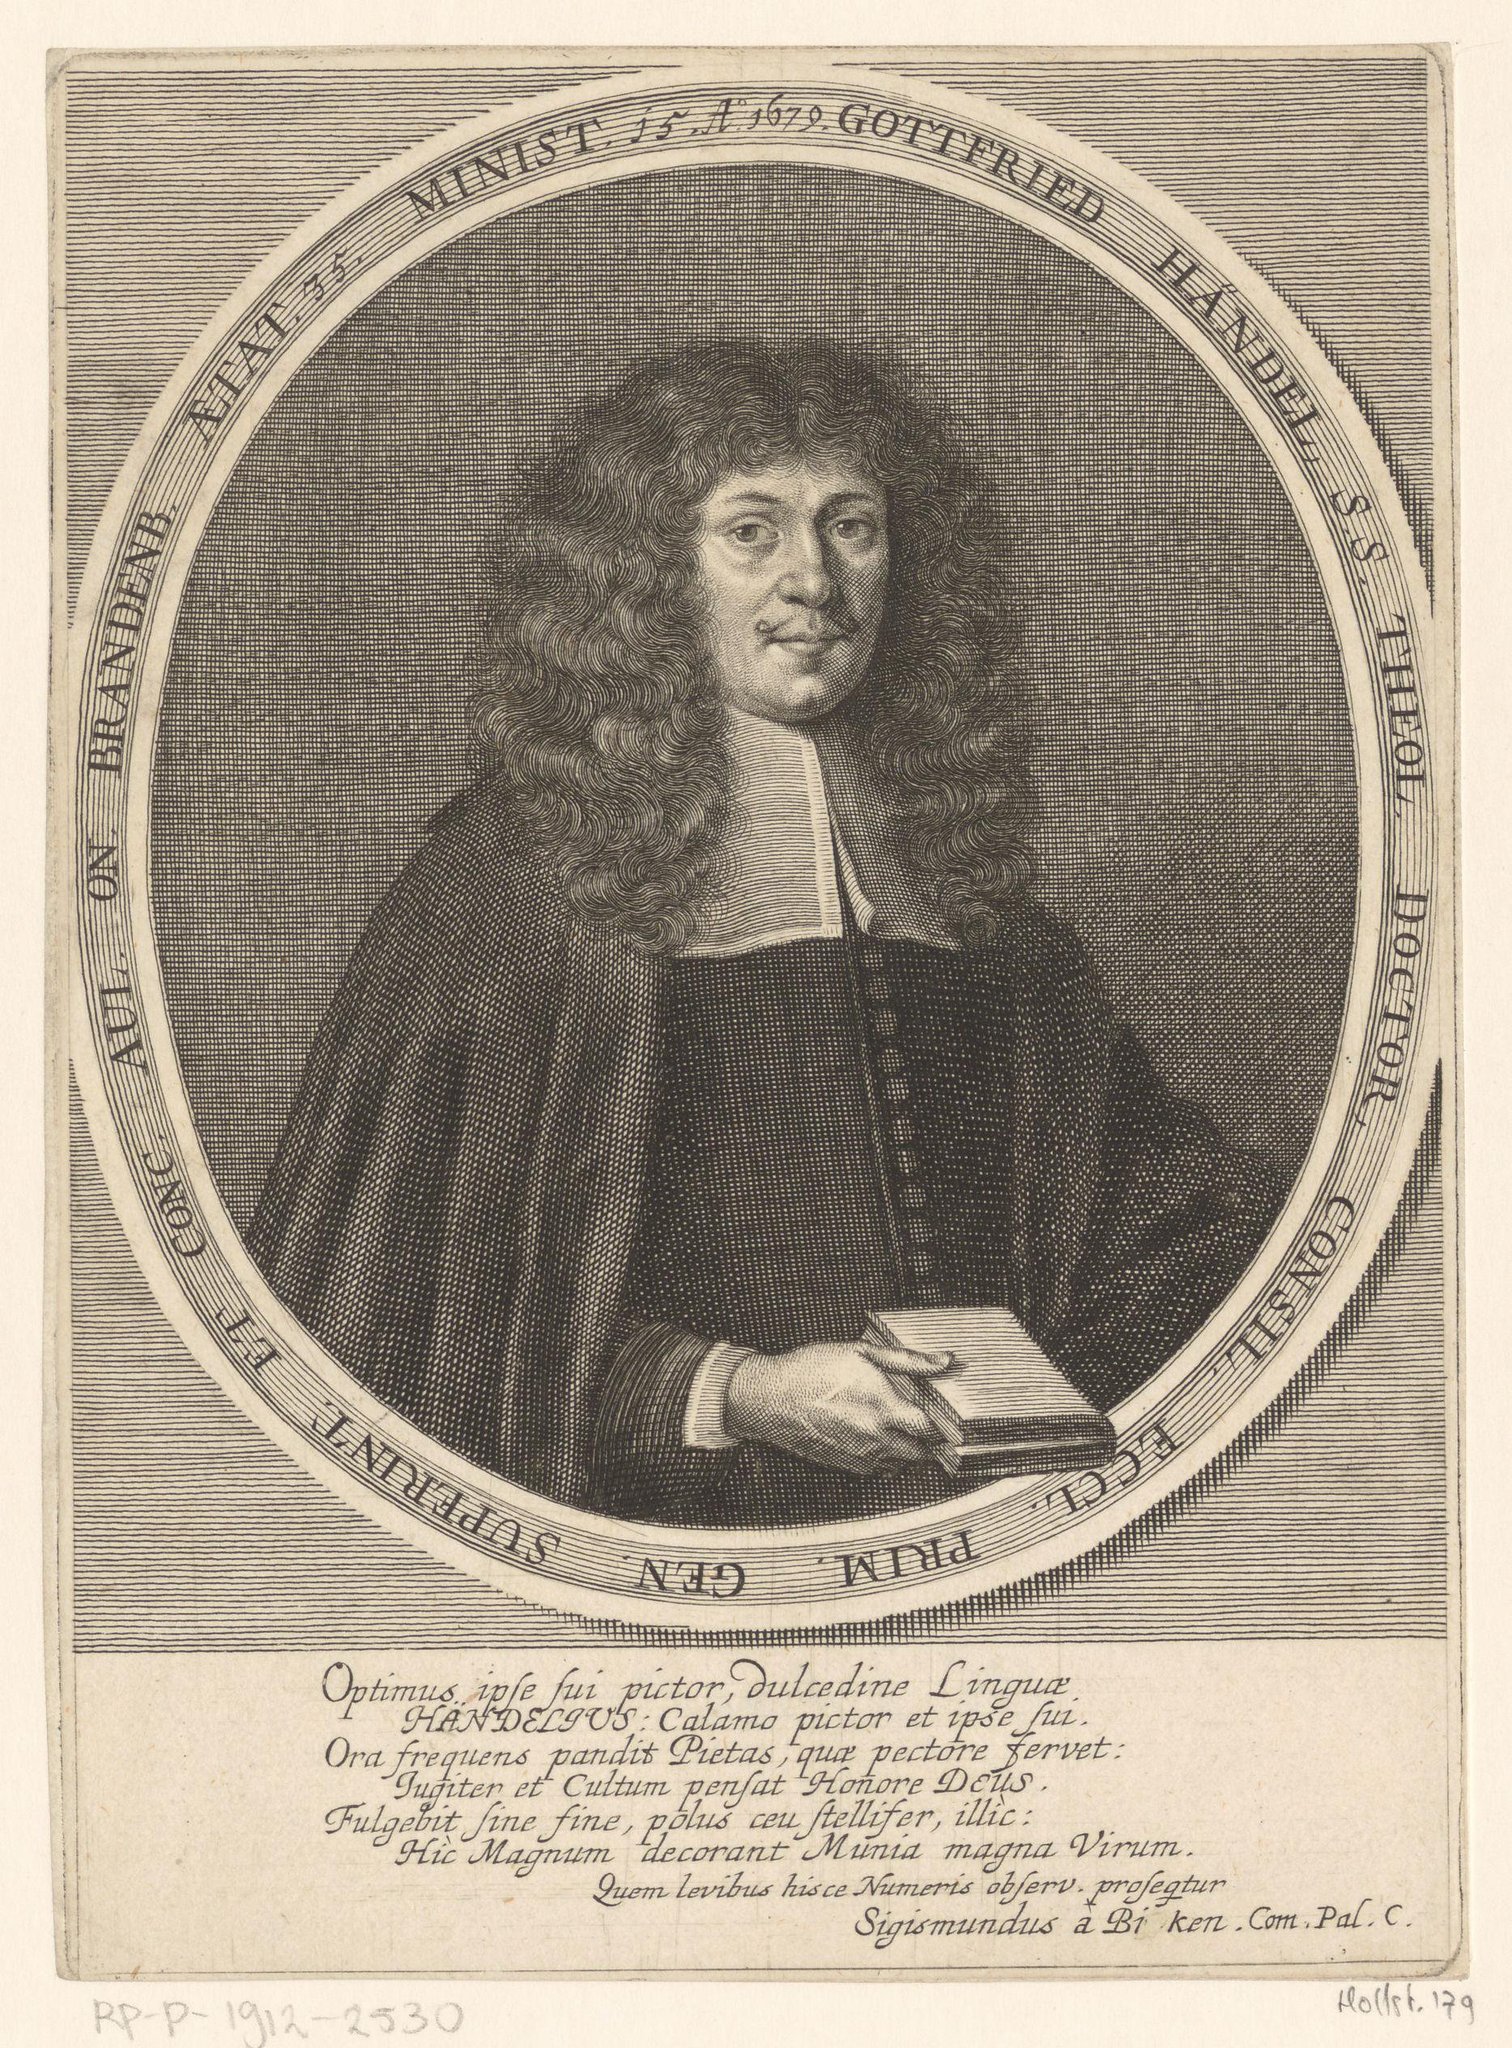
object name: print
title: Portret van Gottfried Händel op 35-jarige leeftijd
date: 1679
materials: paper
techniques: engraving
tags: gottfried händel, theologian, historical persons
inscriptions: collector's mark: Lugt 2228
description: Tekst in het Latijn in de omlijsting en in de ondermarge.